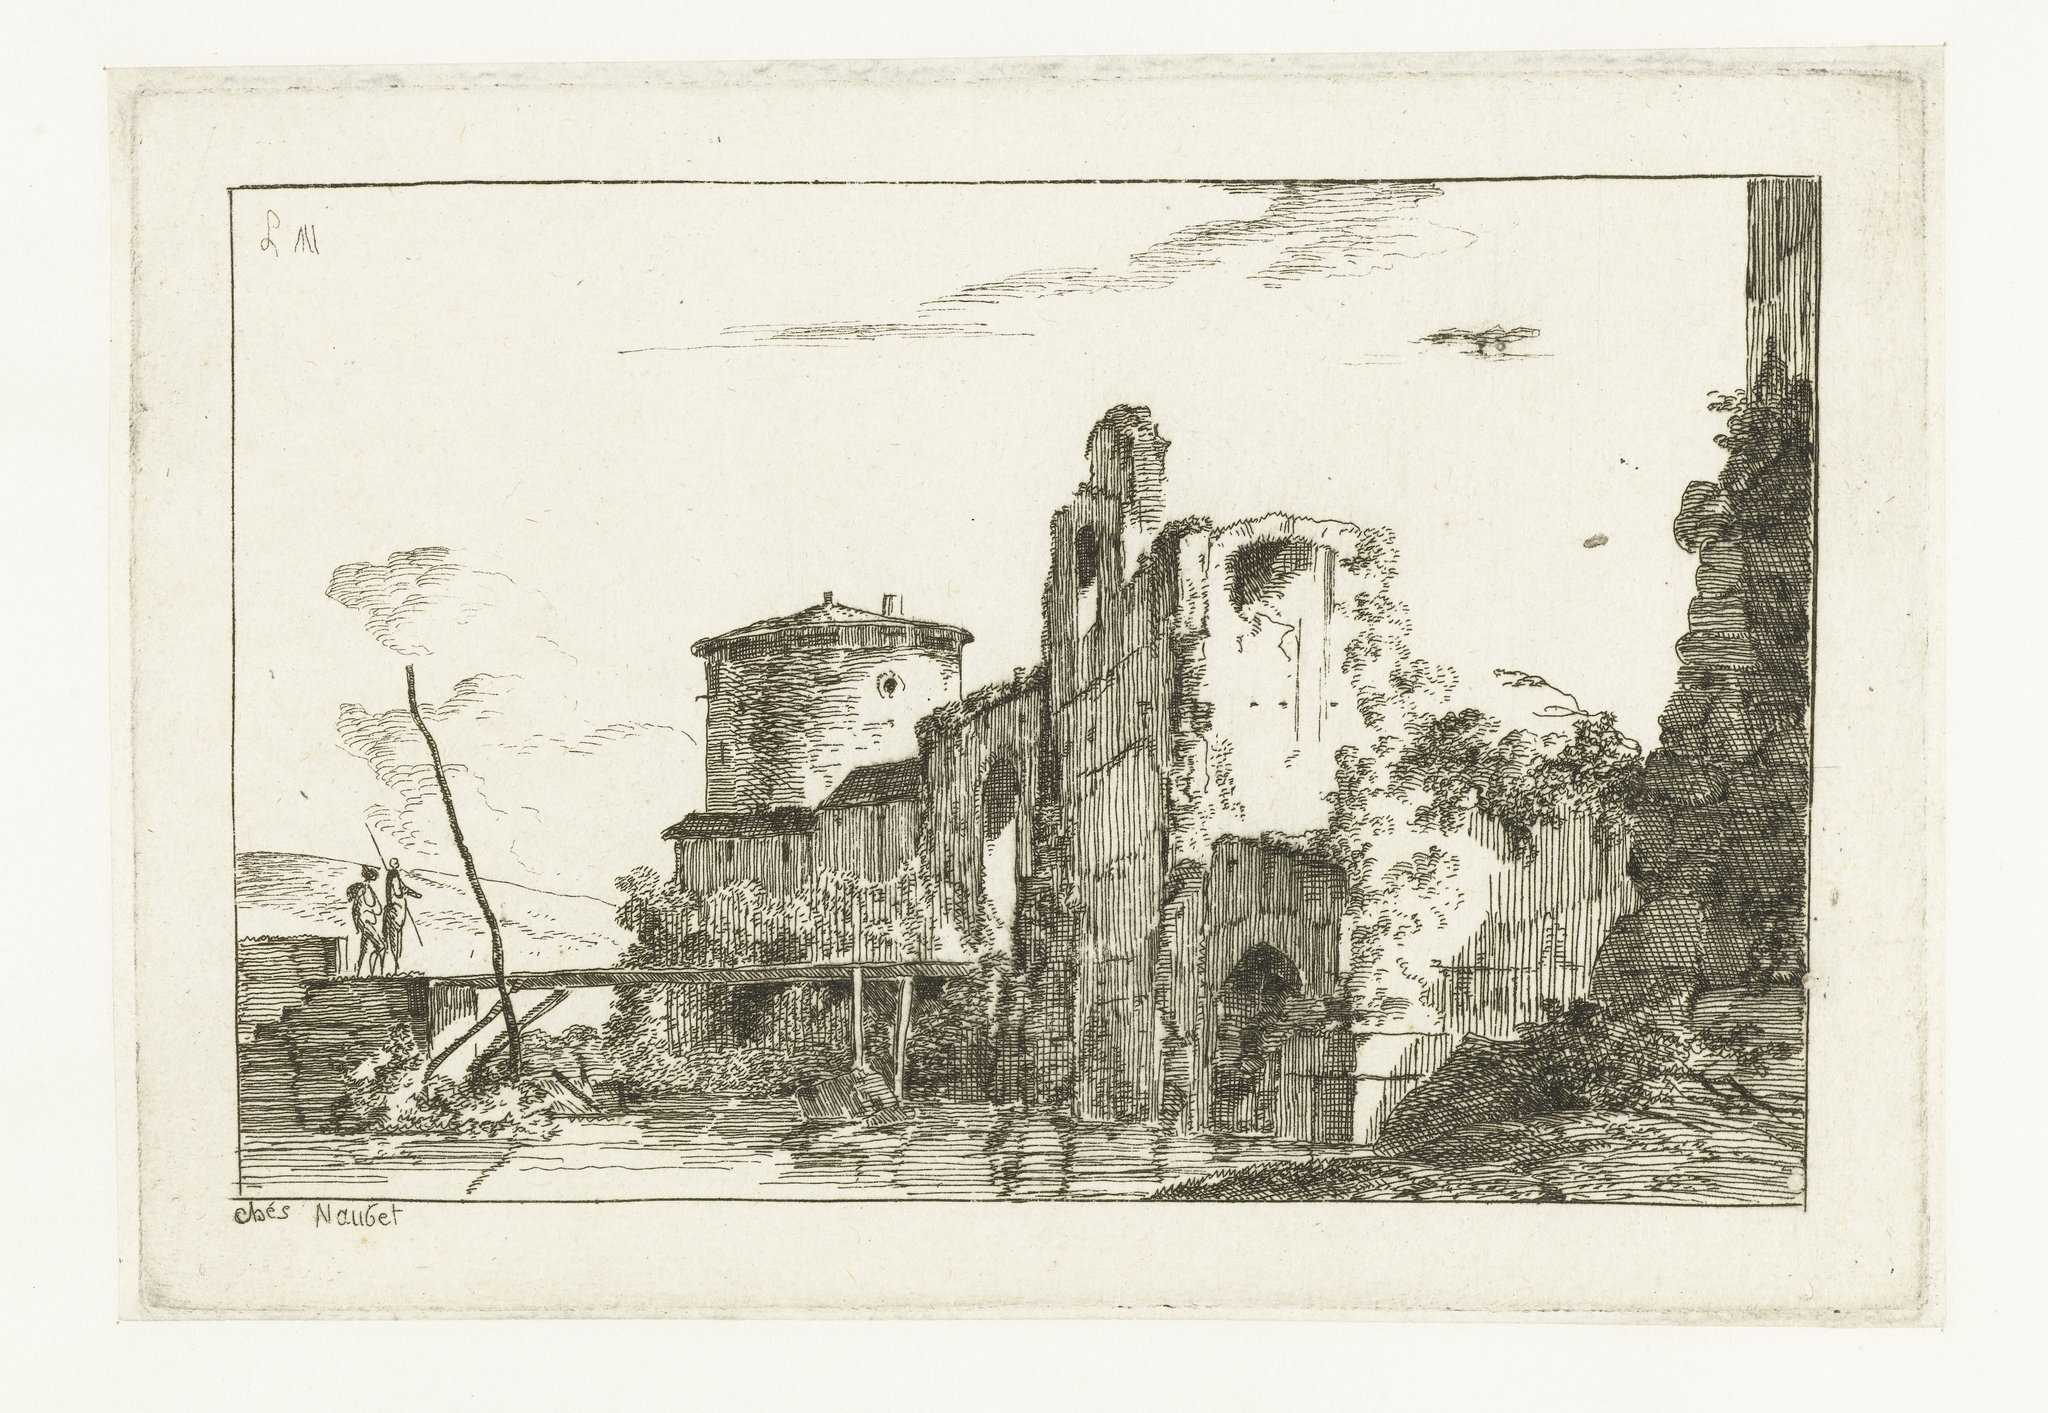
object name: print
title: Fort en een brug over de rivier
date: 1770-1825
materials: paper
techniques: etching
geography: paris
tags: landscape with ruins, bridge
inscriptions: collector's mark: Lugt 2200, collector's mark: Lugt 2228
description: Een ruïne van een fort aan een rivier, met een grote ronde toren. Over de rivier een kleine houten brug met twee wandelaars.